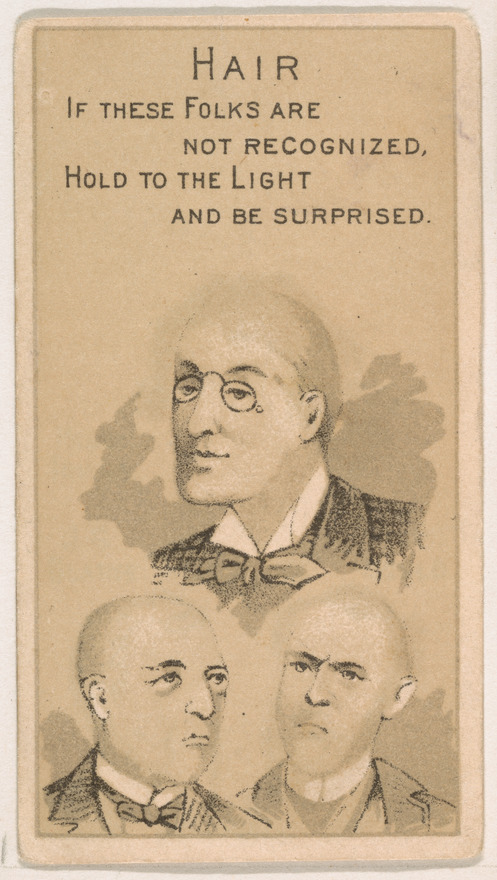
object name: print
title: Hair, from the Magic Changing Cards series (N223) issued by Kinney Tobacco Company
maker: kinney brothers tobacco company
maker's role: publisher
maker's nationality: american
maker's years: 1869-2011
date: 1889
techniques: color lithograph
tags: men